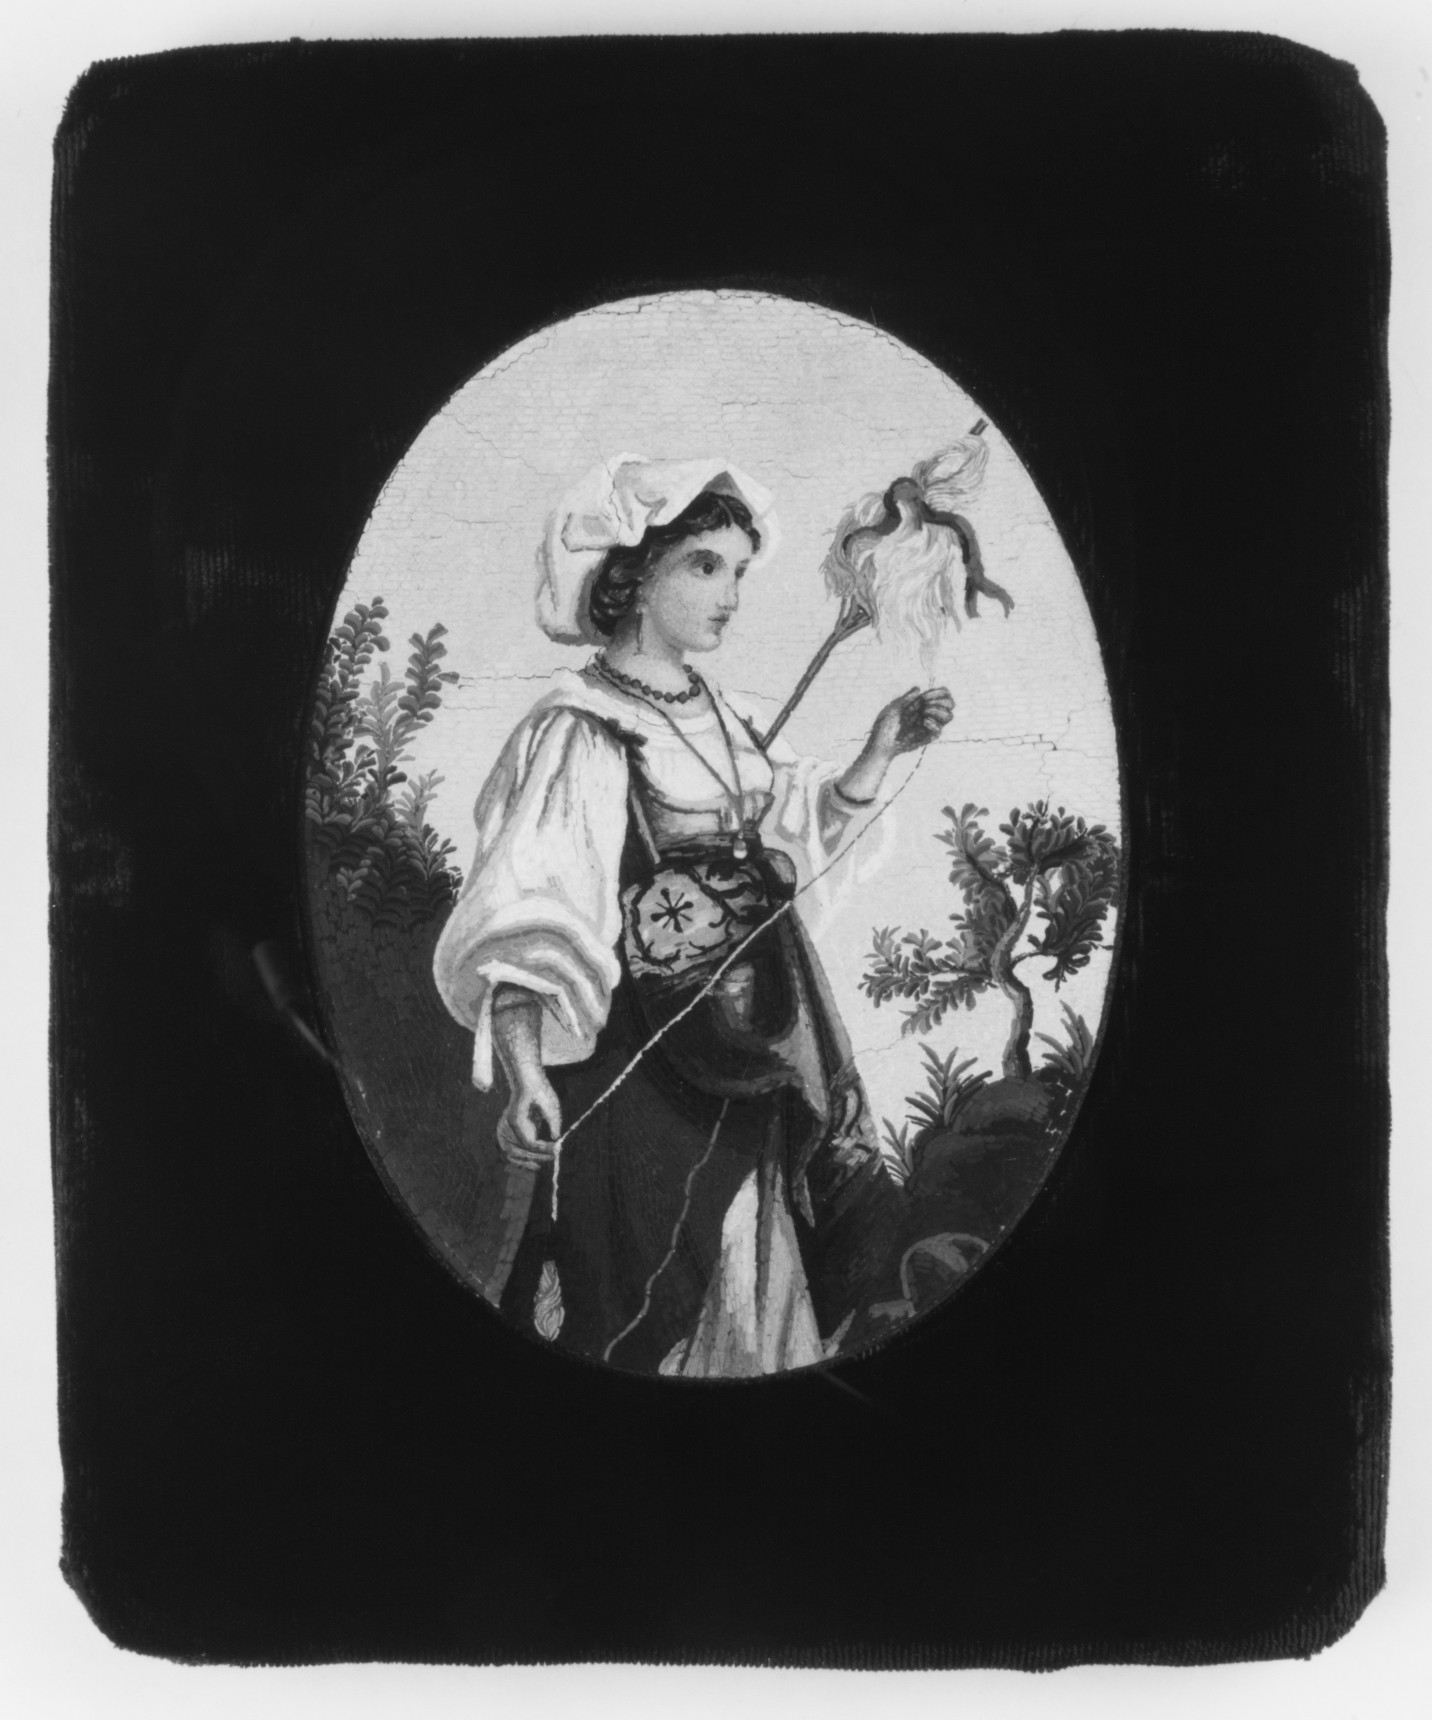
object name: mosaic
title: Roman country girl spinning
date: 1840-1850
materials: gilt bronze, glass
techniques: backing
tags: girls,trees